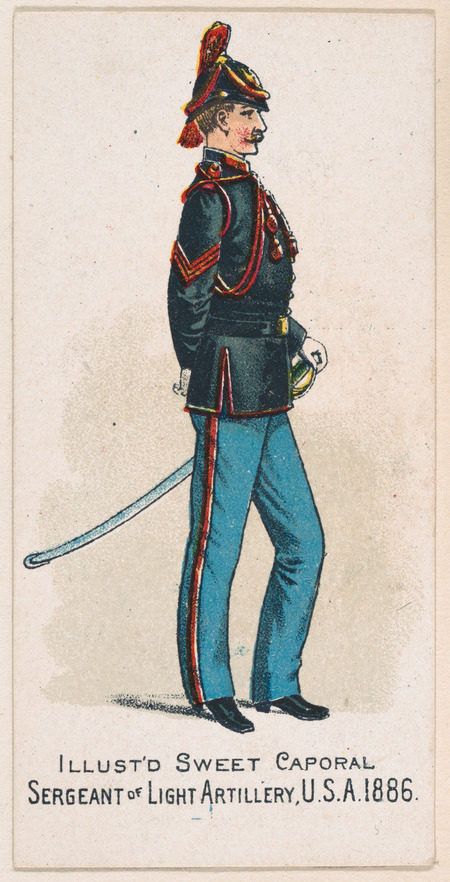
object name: print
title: Sergeant, Light Artillery, United States Army, 1886, from the Military Series (N224) issued by Kinney Tobacco Company to promote Sweet Caporal Cigarettes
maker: kinney brothers tobacco company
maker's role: publisher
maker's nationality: american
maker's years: 1869-2011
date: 1888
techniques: color lithograph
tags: army,swords,men,profiles